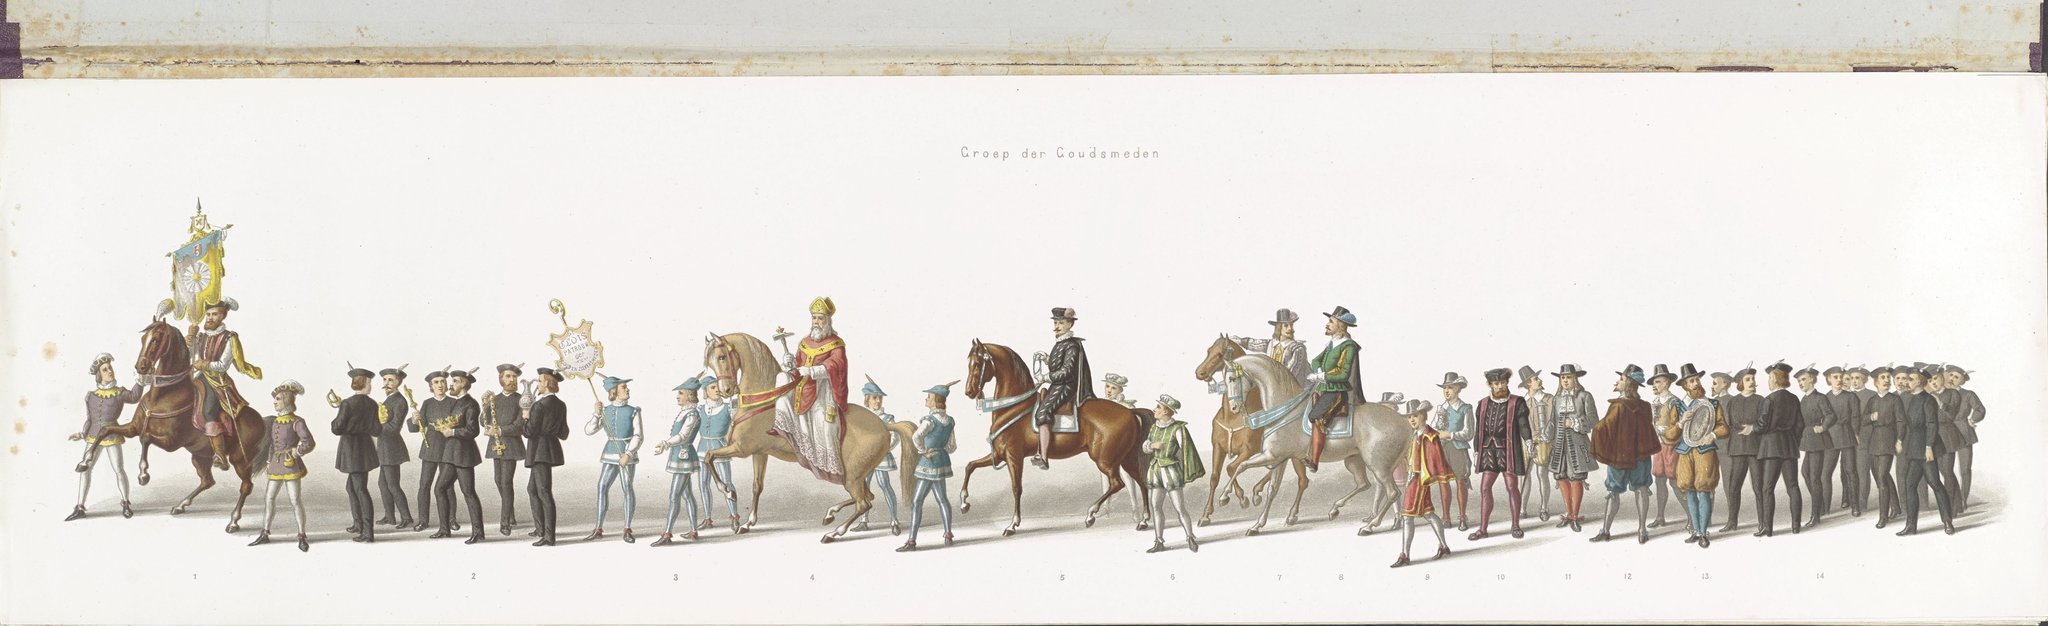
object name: print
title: Gecostumeerde Historische Optocht bij de viering van het 25-jarig regeerings-jubilé van Z:M: Willem III Koning der Nederlanden. 12 Mei 1874. Gehouden te Amsterdam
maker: Anonymous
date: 1874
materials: paper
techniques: chromolithography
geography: amsterdam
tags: brussels, willem iii (koning der nederlanden), festivities on events of national importance (+ parade, pageant, cavalcade ~ festive activities), costumes used in pageants, amsterdam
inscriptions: collector's mark: Lugt 2228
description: Groep van de goud- en zilversmeden. Achtste groep, de figuren genummerd 1-14. Onderdeel van de groep van negen platen van de gekostumeerde historische optocht gehouden te Amsterdam bij de viering van het 25-jarig regeringsjubileum van koning Willem III op 12 mei 1874.